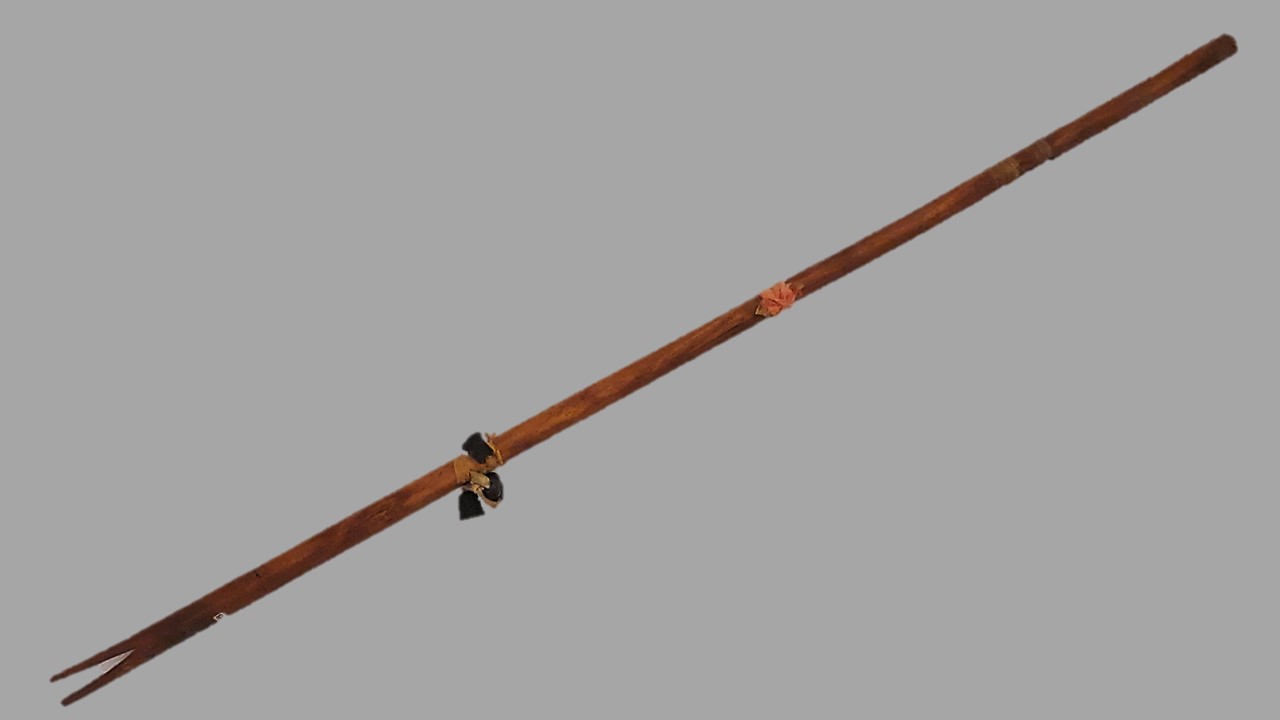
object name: whistle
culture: native american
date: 1801-1900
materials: metal, ribbon, wood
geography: united states